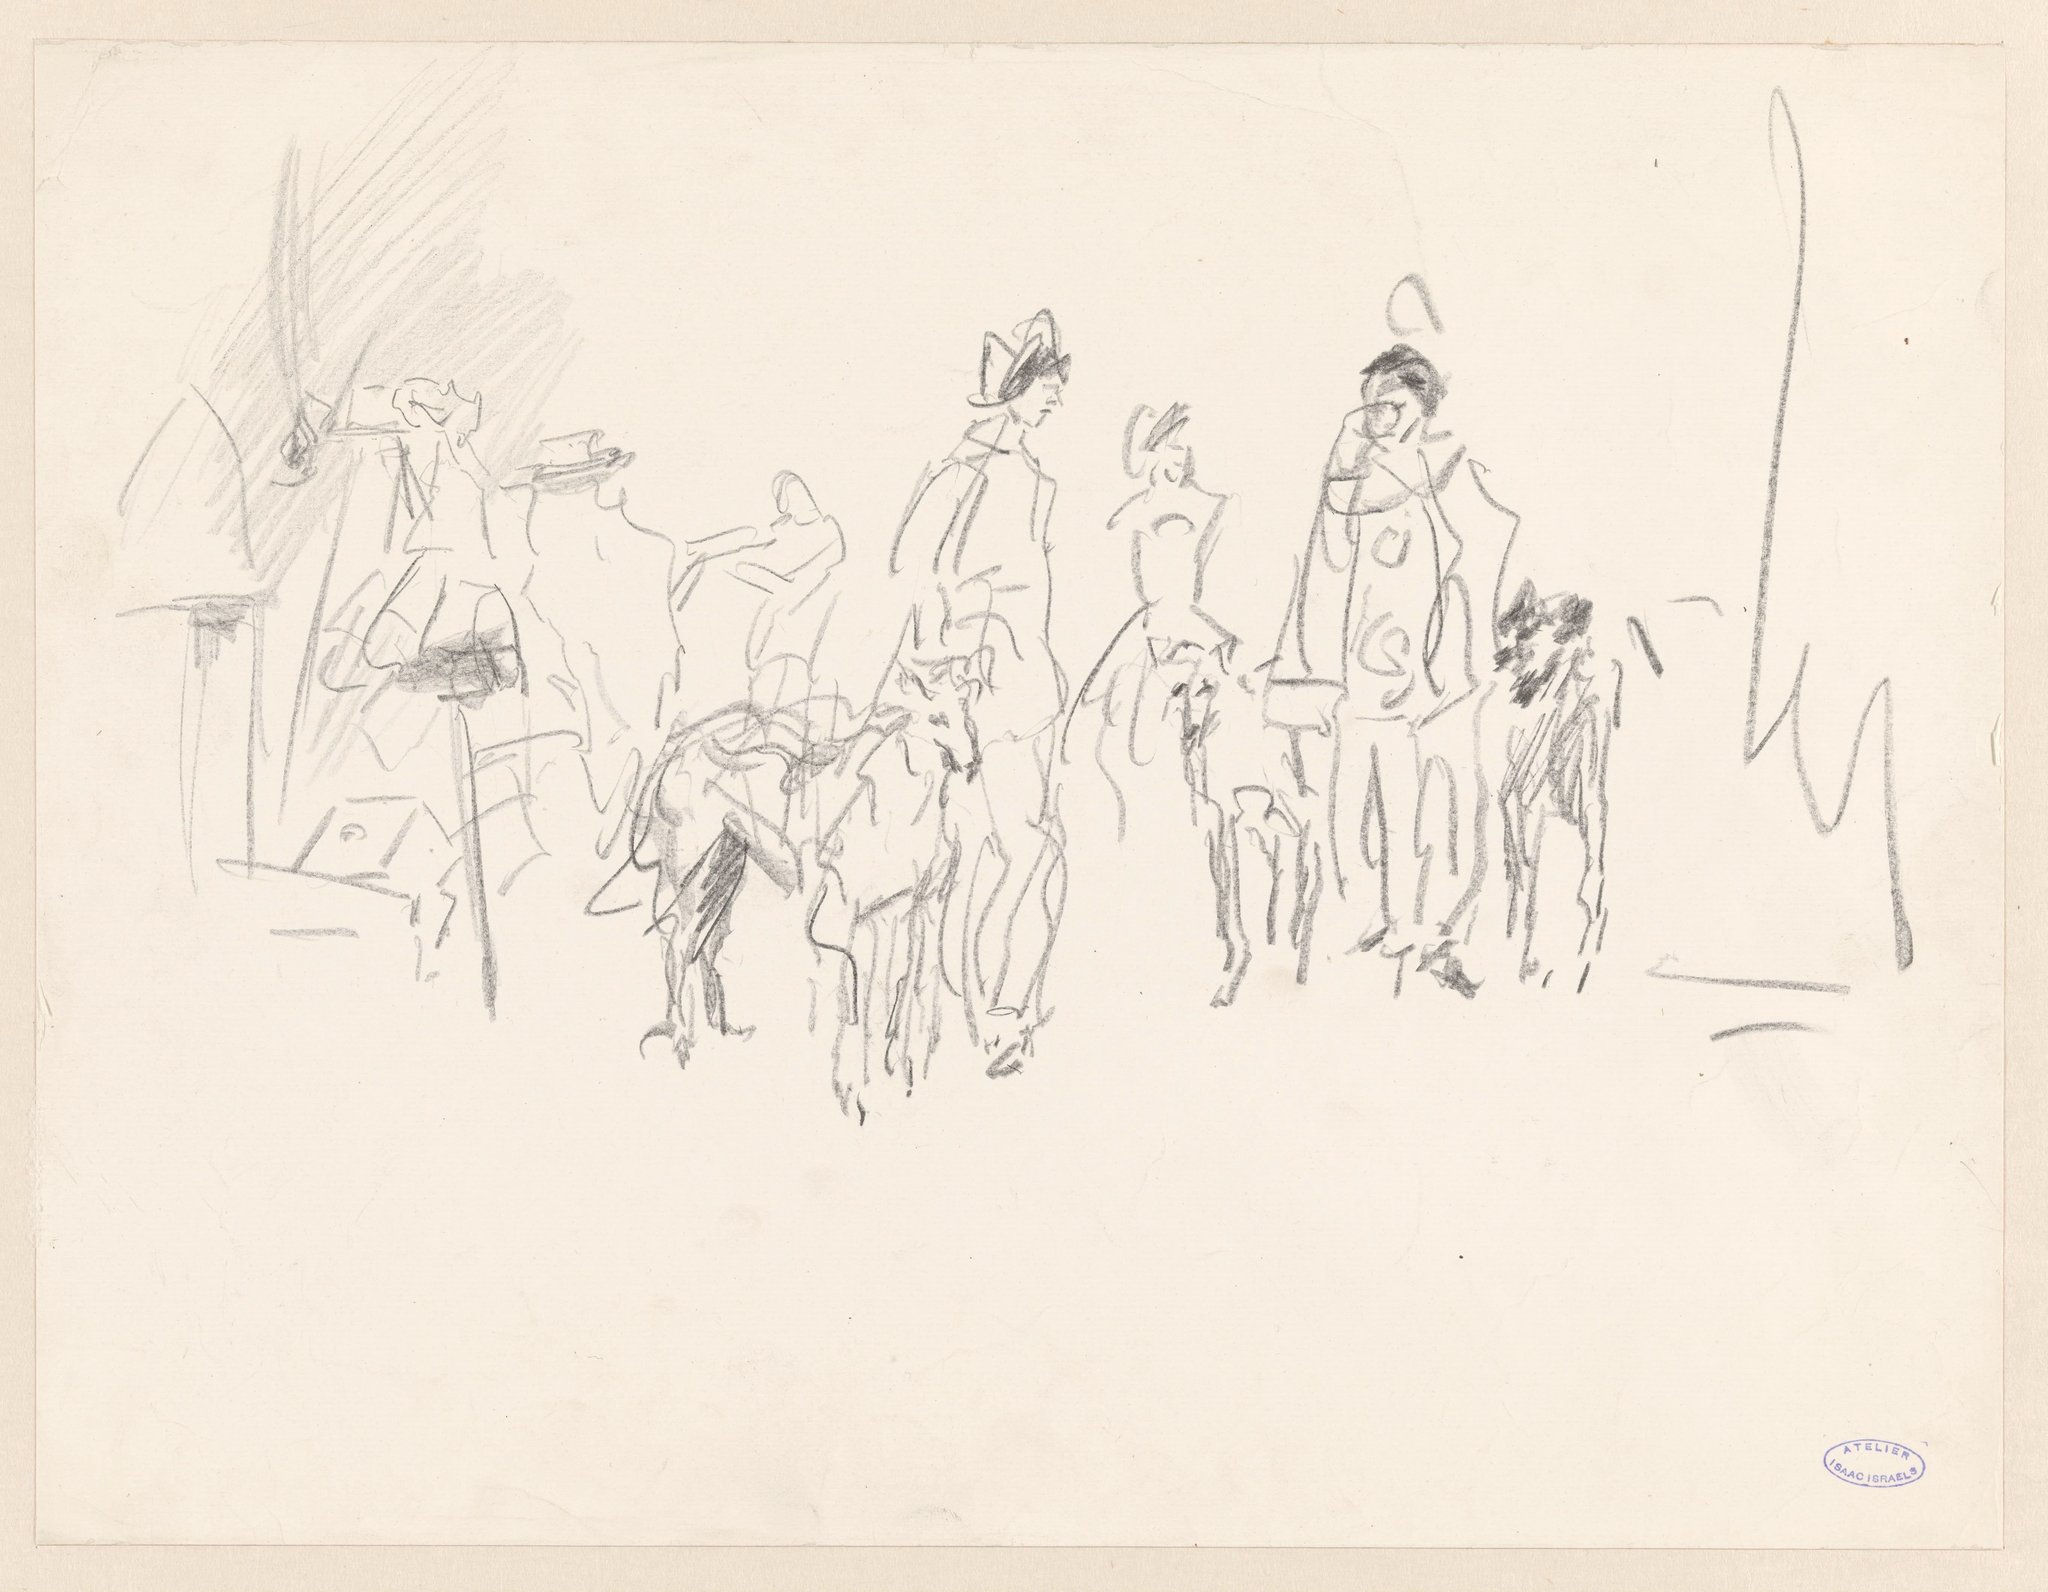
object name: drawing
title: Groep artiesten met honden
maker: isaac israels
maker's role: draughtsman, painter, print maker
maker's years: 1865-1934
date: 1875-1934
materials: chalk, paper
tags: dogs (circus performance)